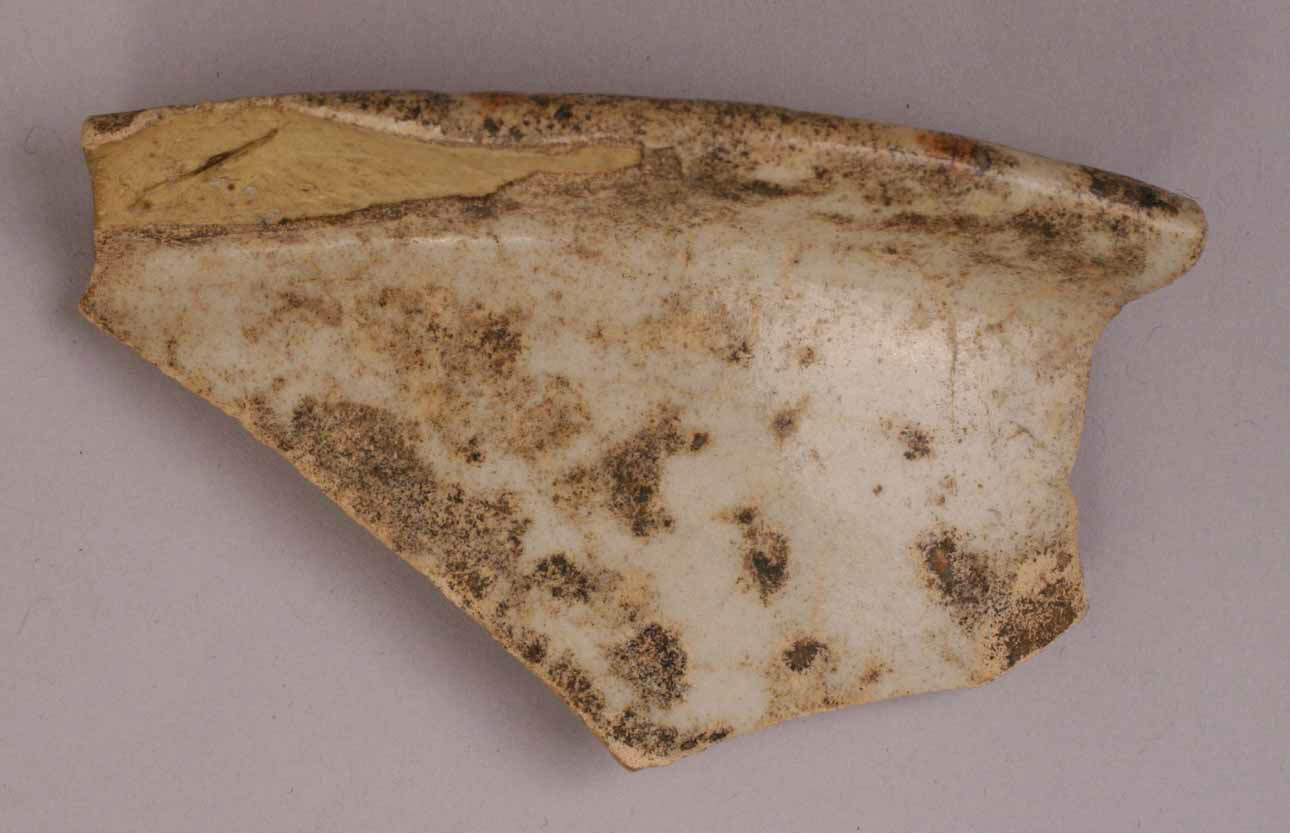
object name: fragment of a bowl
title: Fragment of a Bowl with White Glaze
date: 801-900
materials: earthenware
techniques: glazing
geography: iraq